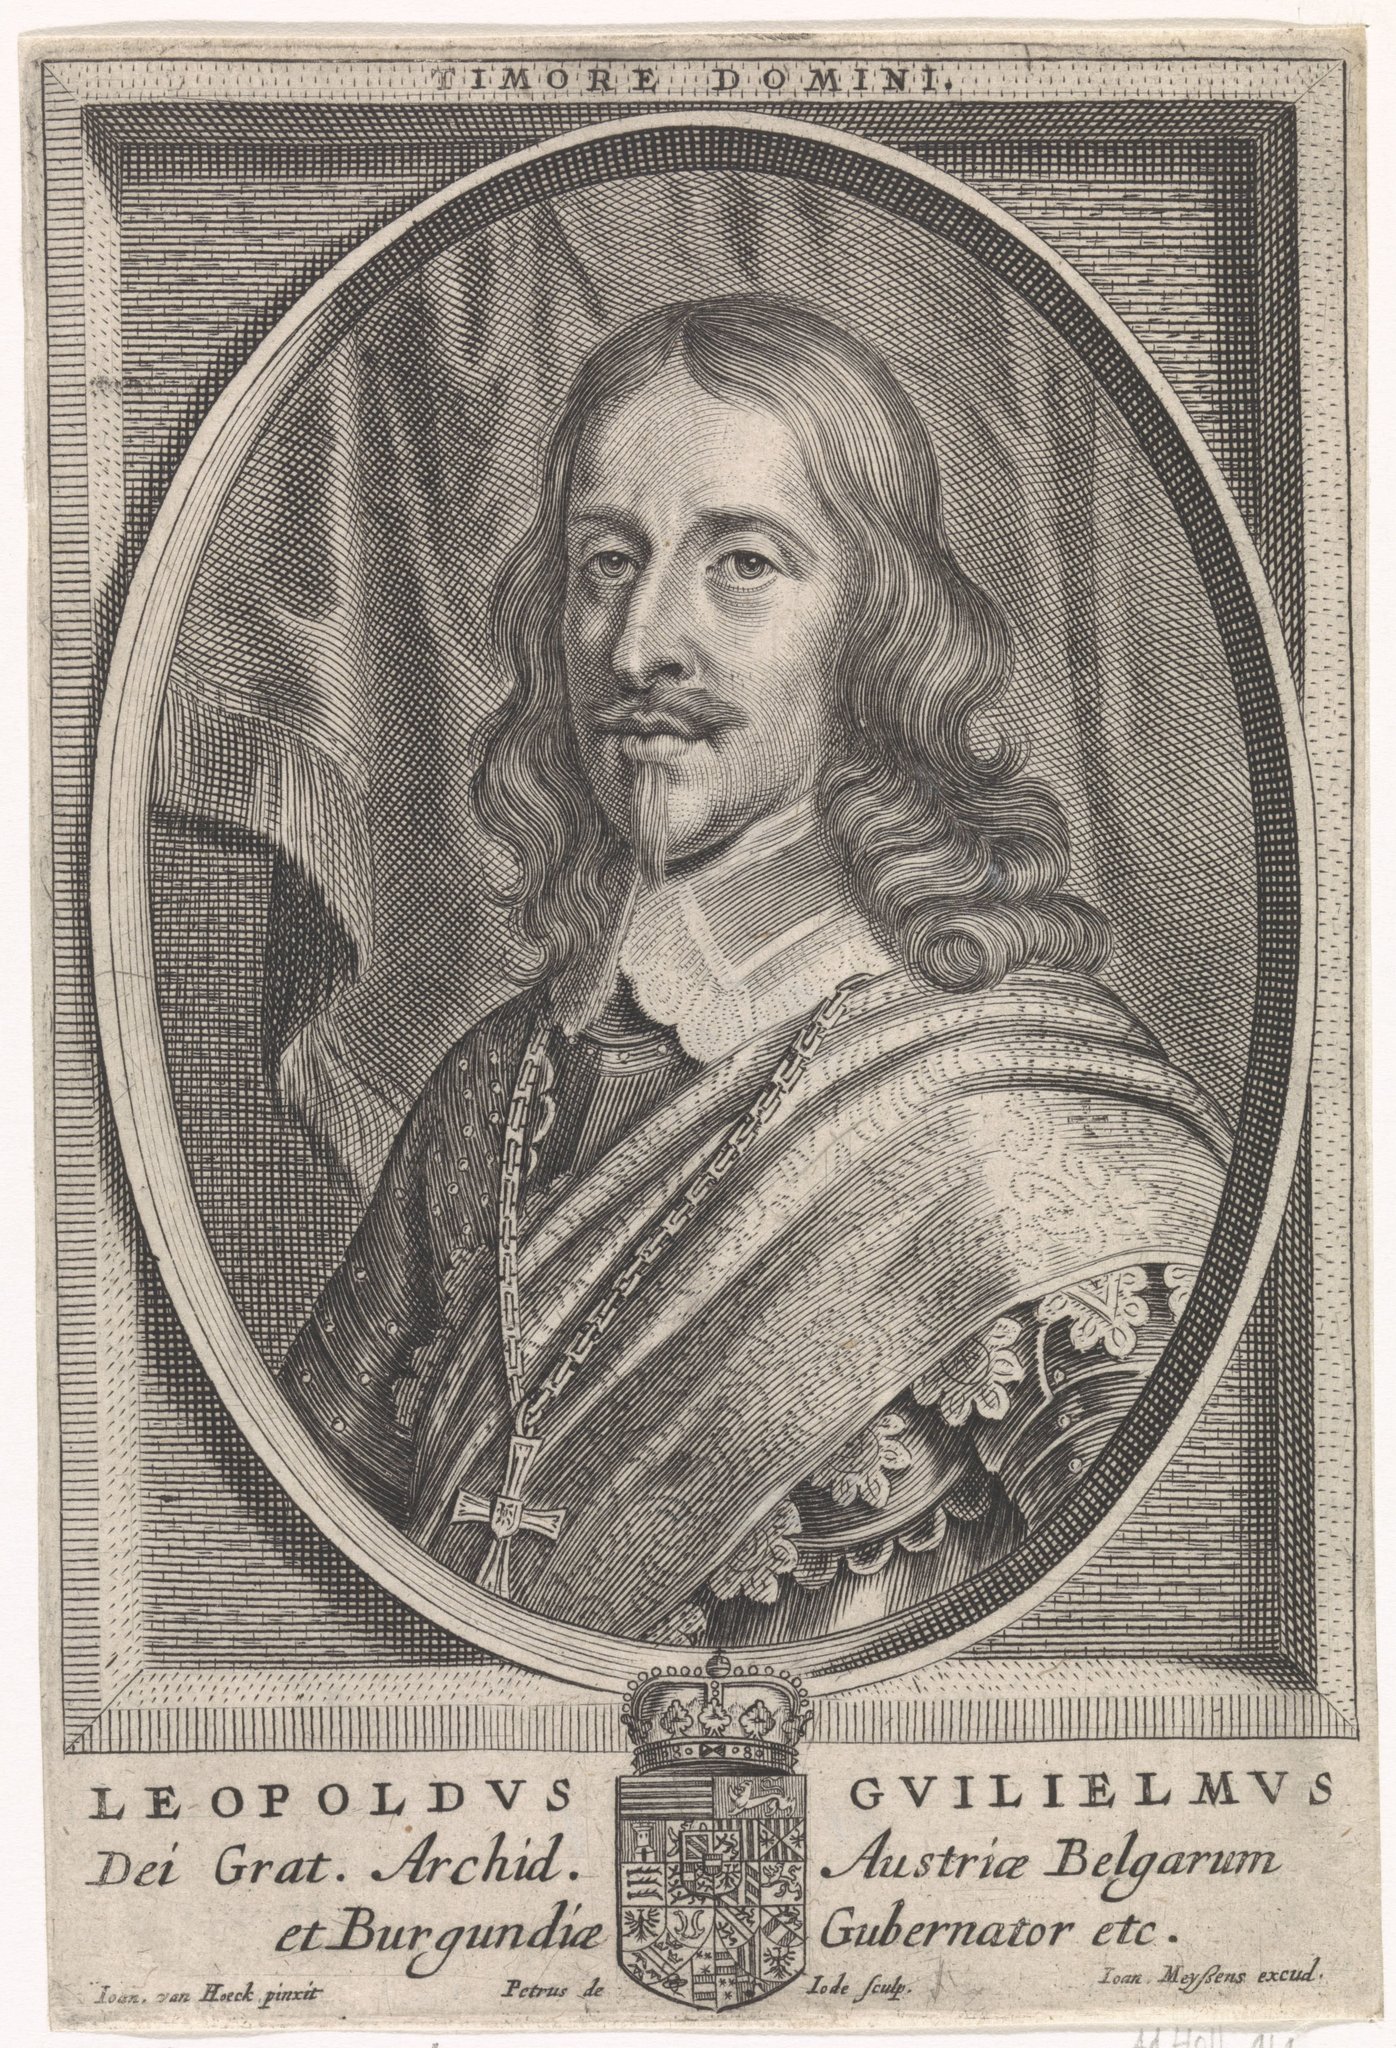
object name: print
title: Theater van bisschoppen, keizers, koningen, hertogen, prinsen, enz.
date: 1628-1670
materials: paper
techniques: engraving, etching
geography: antwerp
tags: vienna, leopold willem van oostenrijk (landvoogd der zuidelijke nederlanden)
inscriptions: collector's mark: Lugt 2228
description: Busteportret van Leopold Willem van Oostenrijk. Het portret is gevat in een ovale omlijsting met vierkant randwerk met een motto in het Latijn. In de marge de naam en het wapenschild van de geportretteerde en een tweeregelig onderschrift in het Latijn.